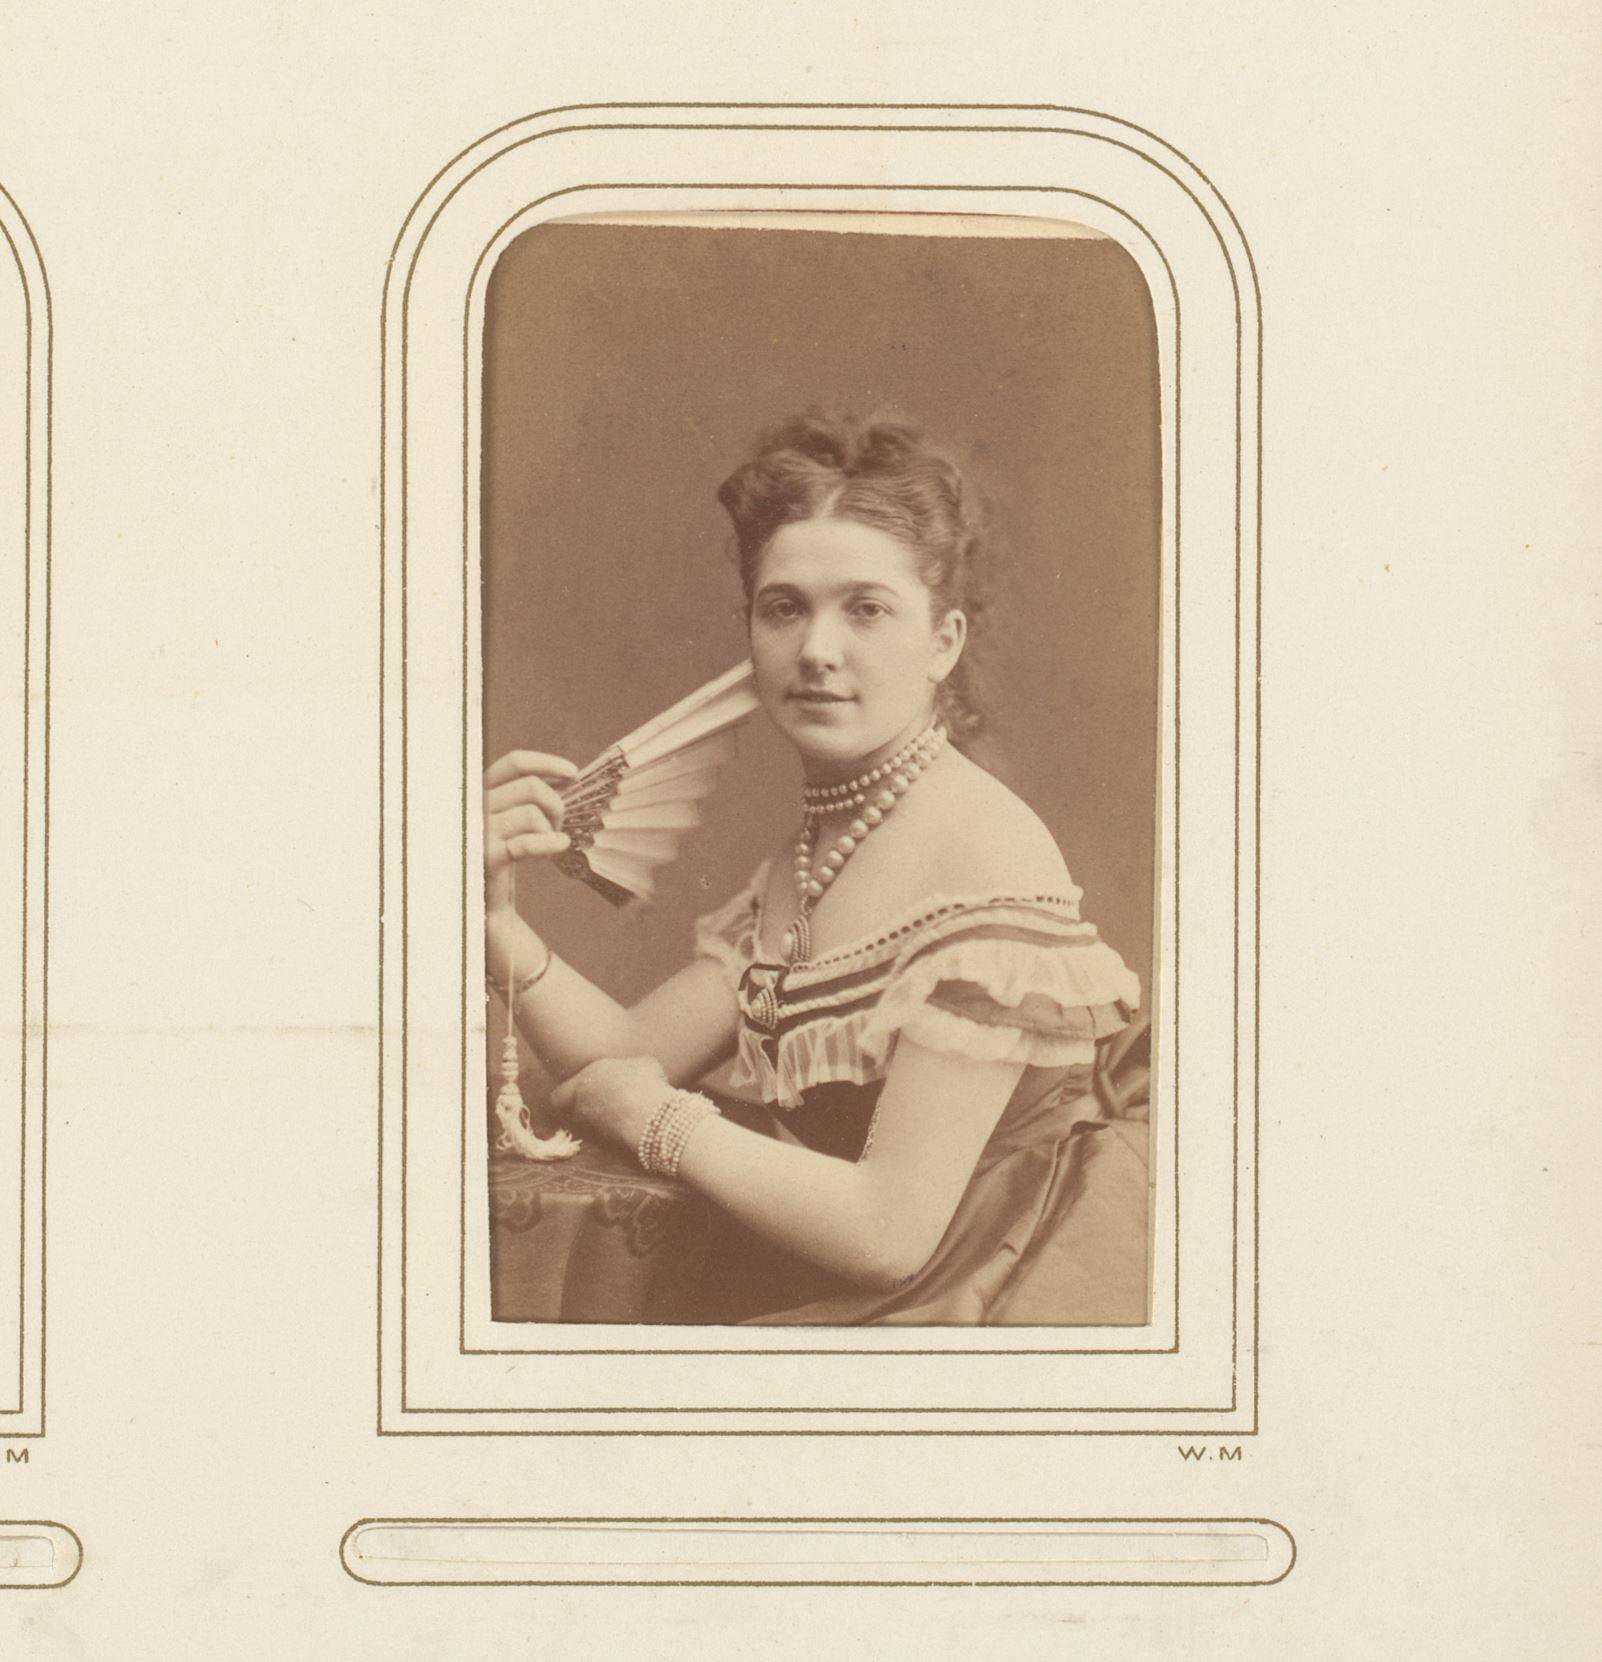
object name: album leaf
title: Portret van Olefina Moe met waaier in de hand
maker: rosalie sophie sjöman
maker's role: fotograaf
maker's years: 1833-1919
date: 1868-1885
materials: cardboard, photographic support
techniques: albumen print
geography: stockholm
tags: historical persons - bb - woman, fan, portrait of actor, actress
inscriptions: annotation: ‘Olefina Moe/ 1850 -’, inscription: ‘Atelier/ För Fotografi/ Rosalie Sjöman/ Stockholm/ No. 42, Drottninggatan No. 42./ öfvergården 2tr. upp/ Plåten förvaras för efterbeställning.’